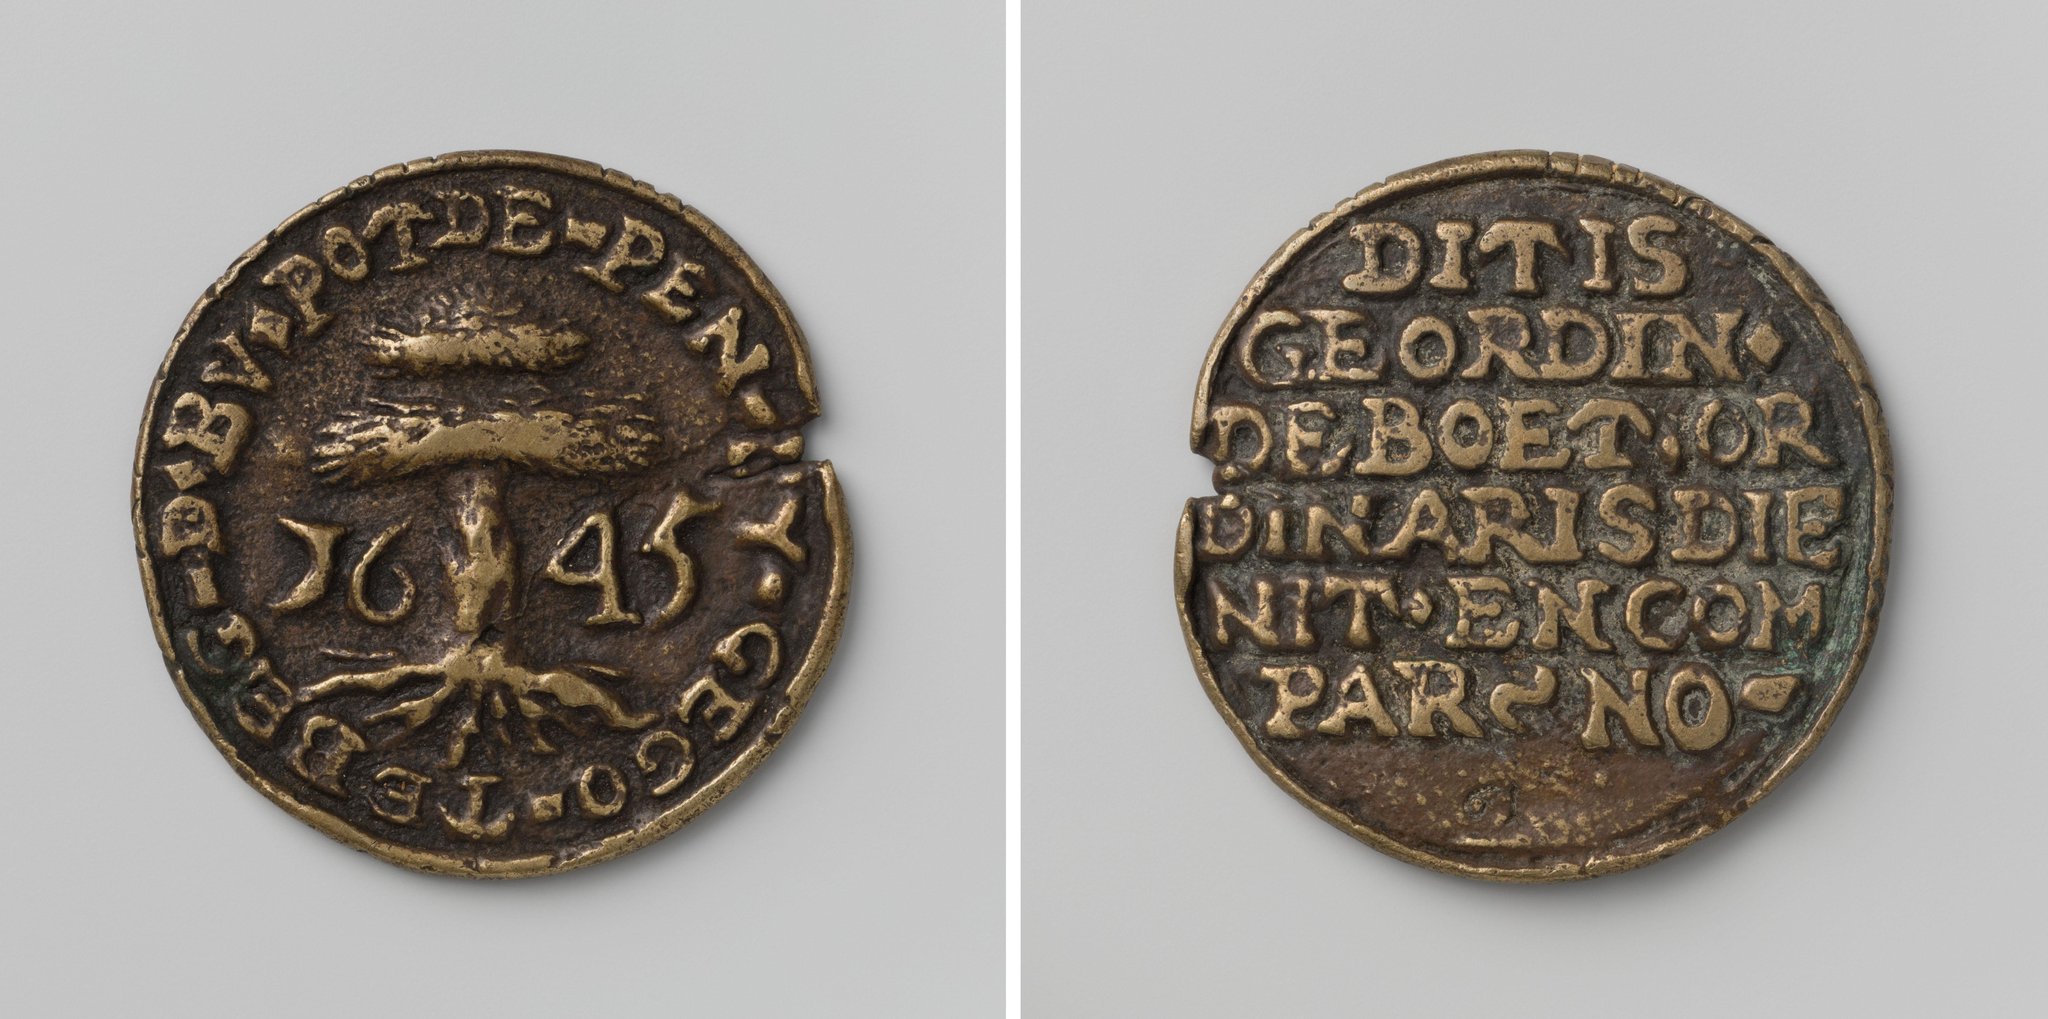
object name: buurtpenning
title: Buurt van de Korte Poten te 's-Gravenhage, buurtpenning met no. 61, no. 65 en no. 4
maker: Anonymous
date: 1645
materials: brass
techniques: casting, engraving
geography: the hague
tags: korte poten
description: Messing penning. Voorzijde: boom tussen jaartal binnen omschrift. Keerzijde: opschrift boven cijfer 61; randschrift: Romeins cijfers XXXXXXIIIII en IIII